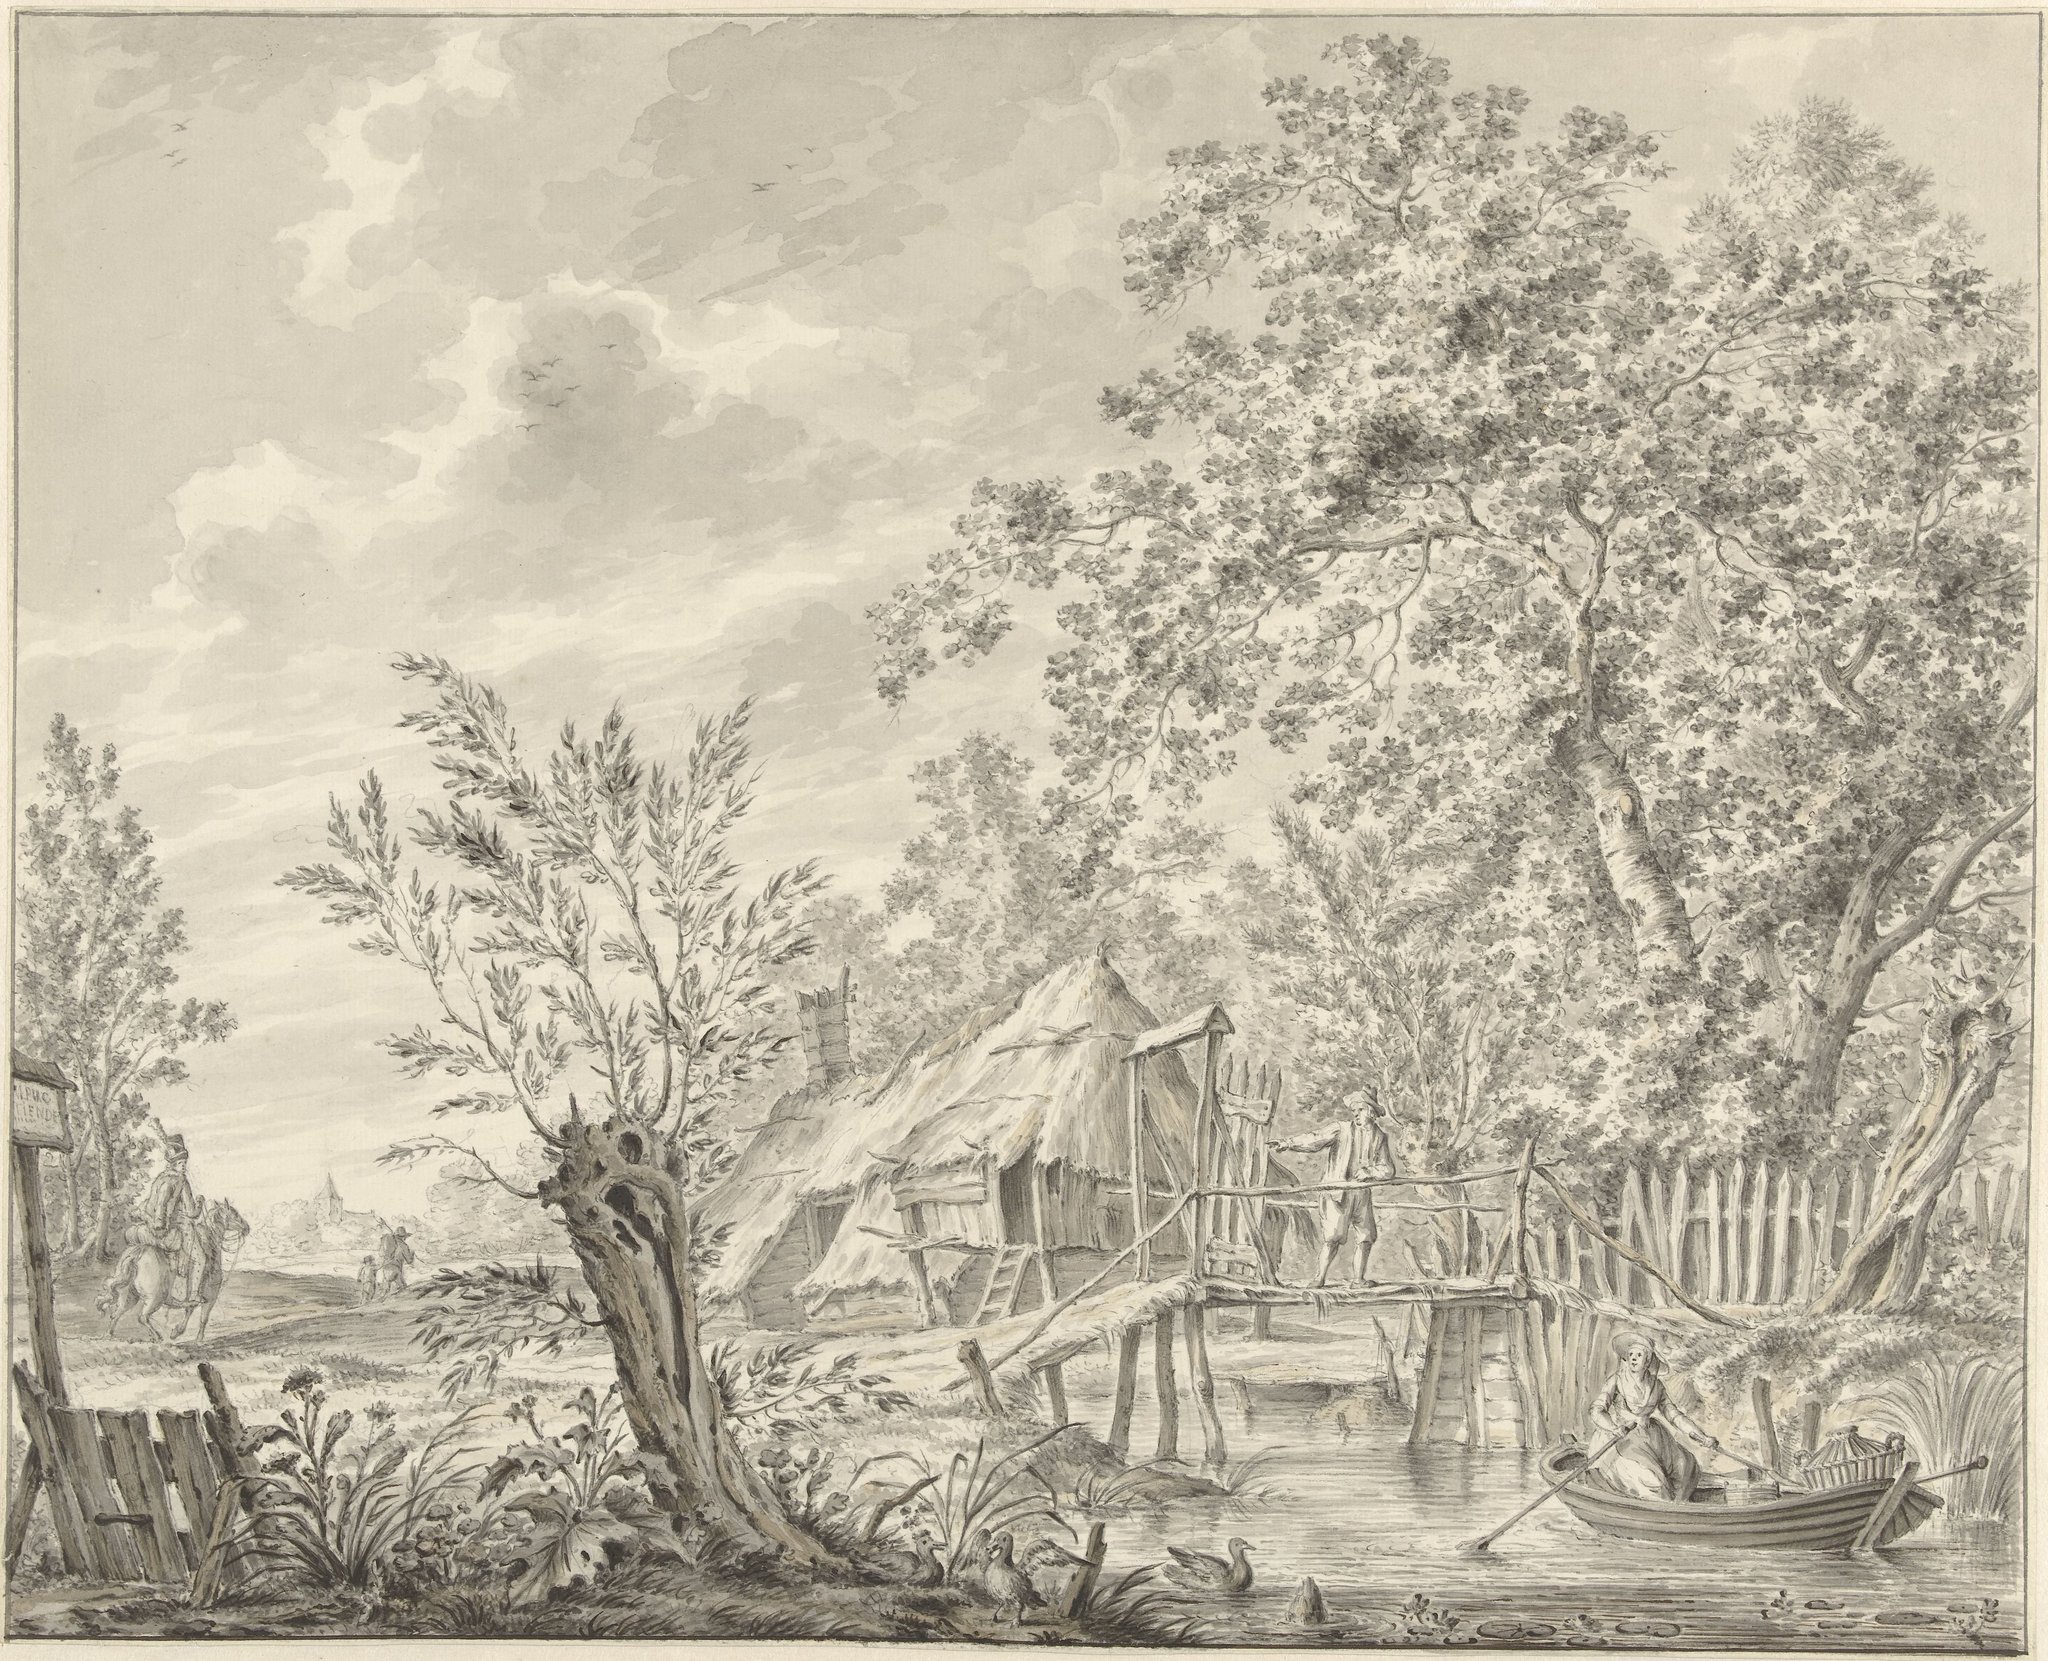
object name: drawing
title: Landschap met een bruggetje en een vrouw in een bootje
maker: johannes jelgerhuis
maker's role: draughtsman, painter, print maker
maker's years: 1770-1836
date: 1795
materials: chalk, paper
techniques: brush